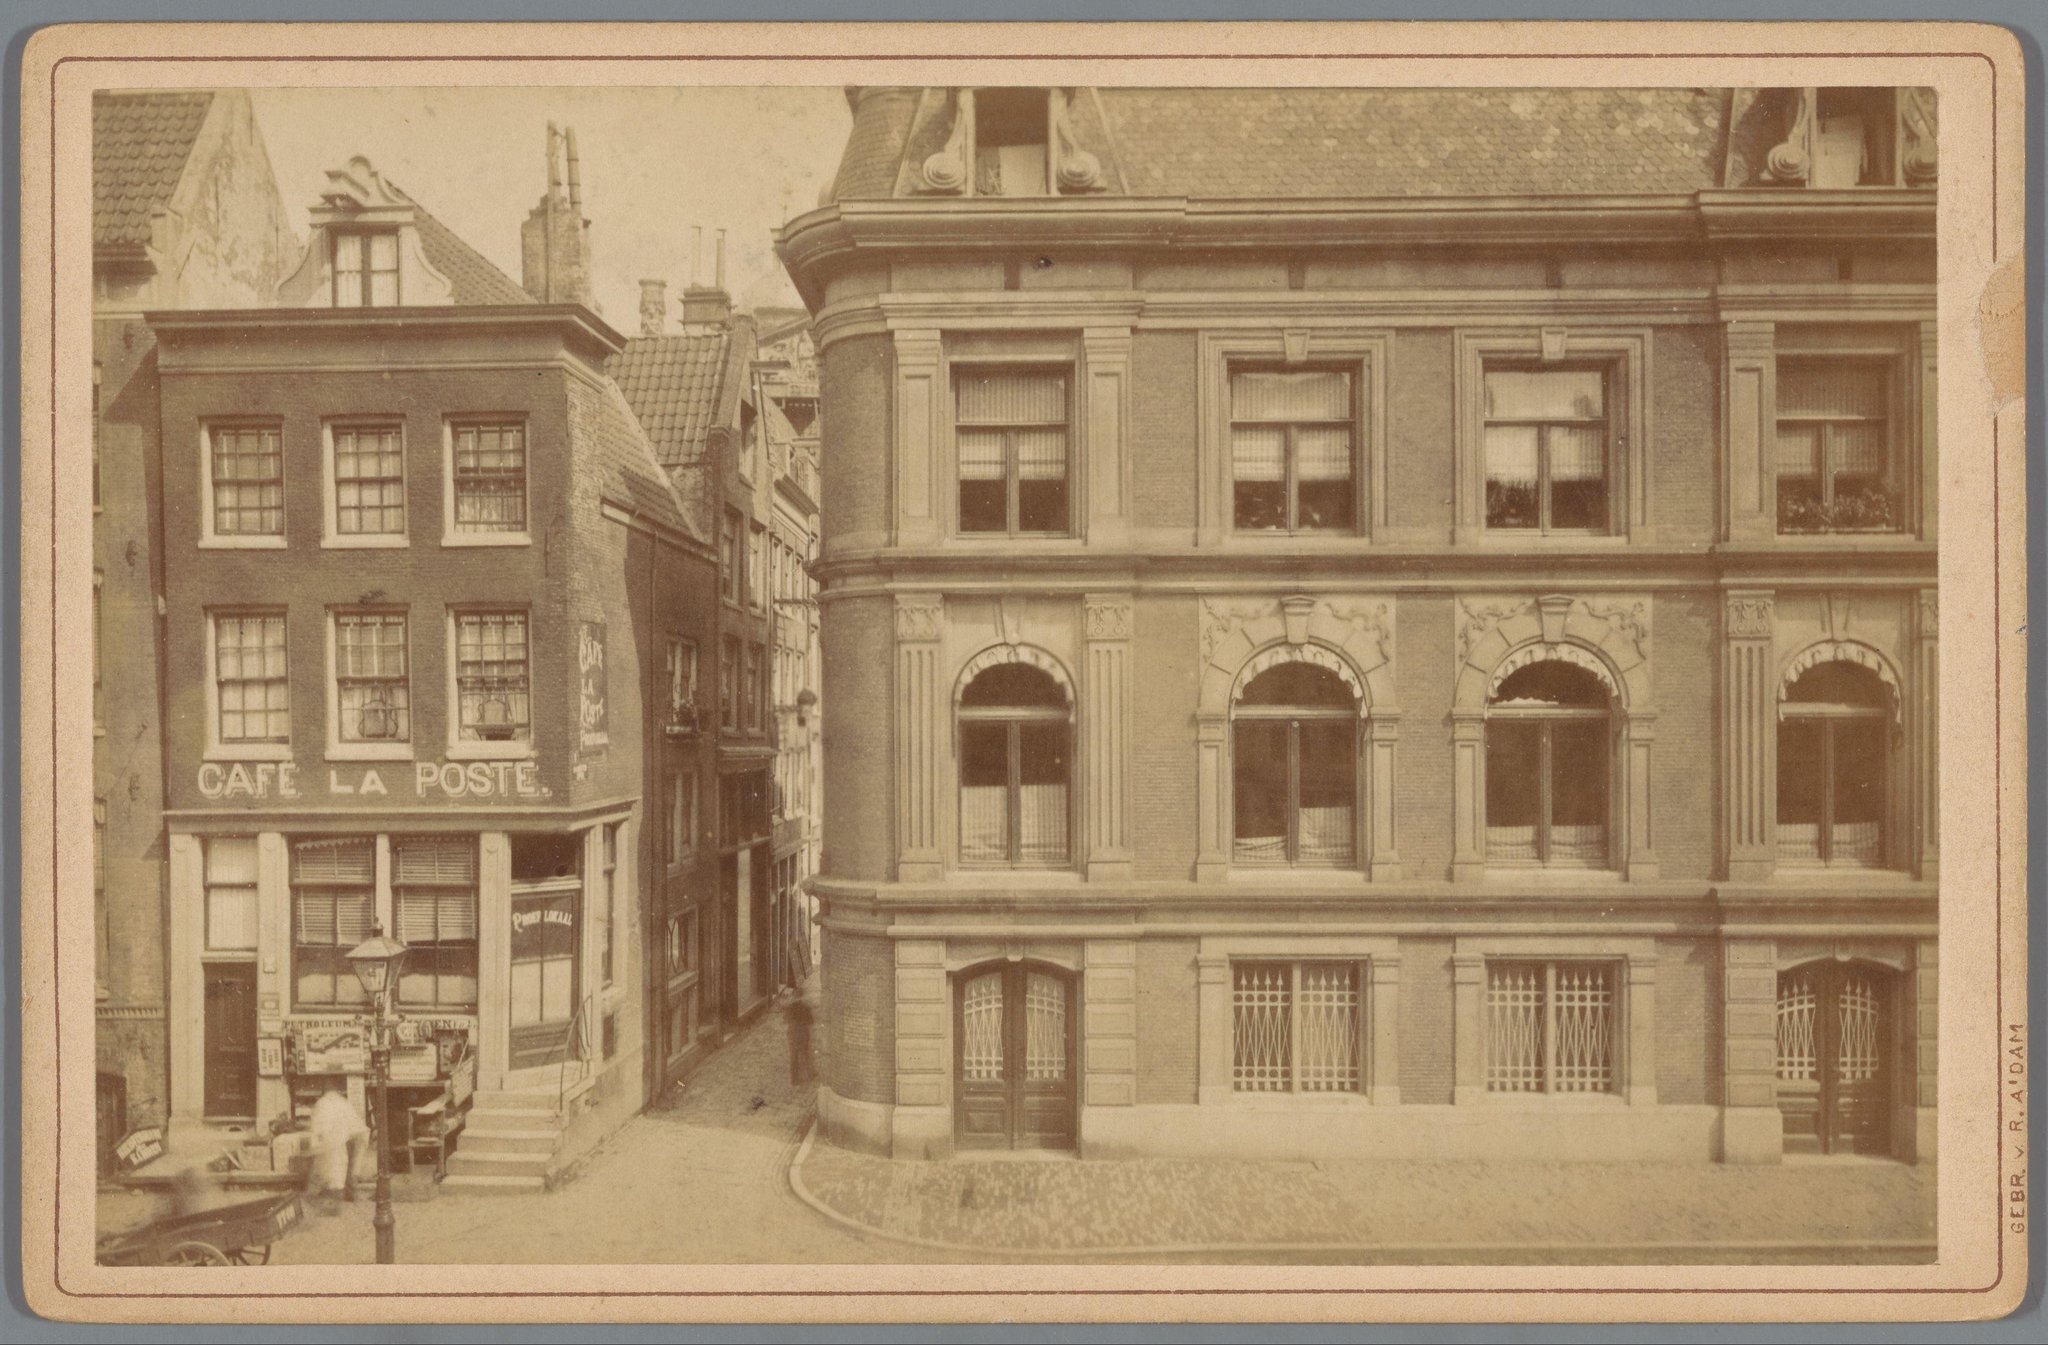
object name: cabinet photograph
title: Gezicht op het voormalige kantoor van Jacob Ankersmit en Café La Poste in Amsterdam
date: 1860-1880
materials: cardboard, photographic support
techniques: albumen print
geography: amsterdam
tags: inn, coffee-house, public house, etc., the usual house or row of houses, office (~ administration), street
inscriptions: inscription: ‘Hetvoormalige kantoor van de Heer Jacob Ankersmit, hoek Spuistraat en voormalige Huiszittensteeg - [...] afgebroken en nu de Raadhuistraat’, name: ‘Vosmaer’